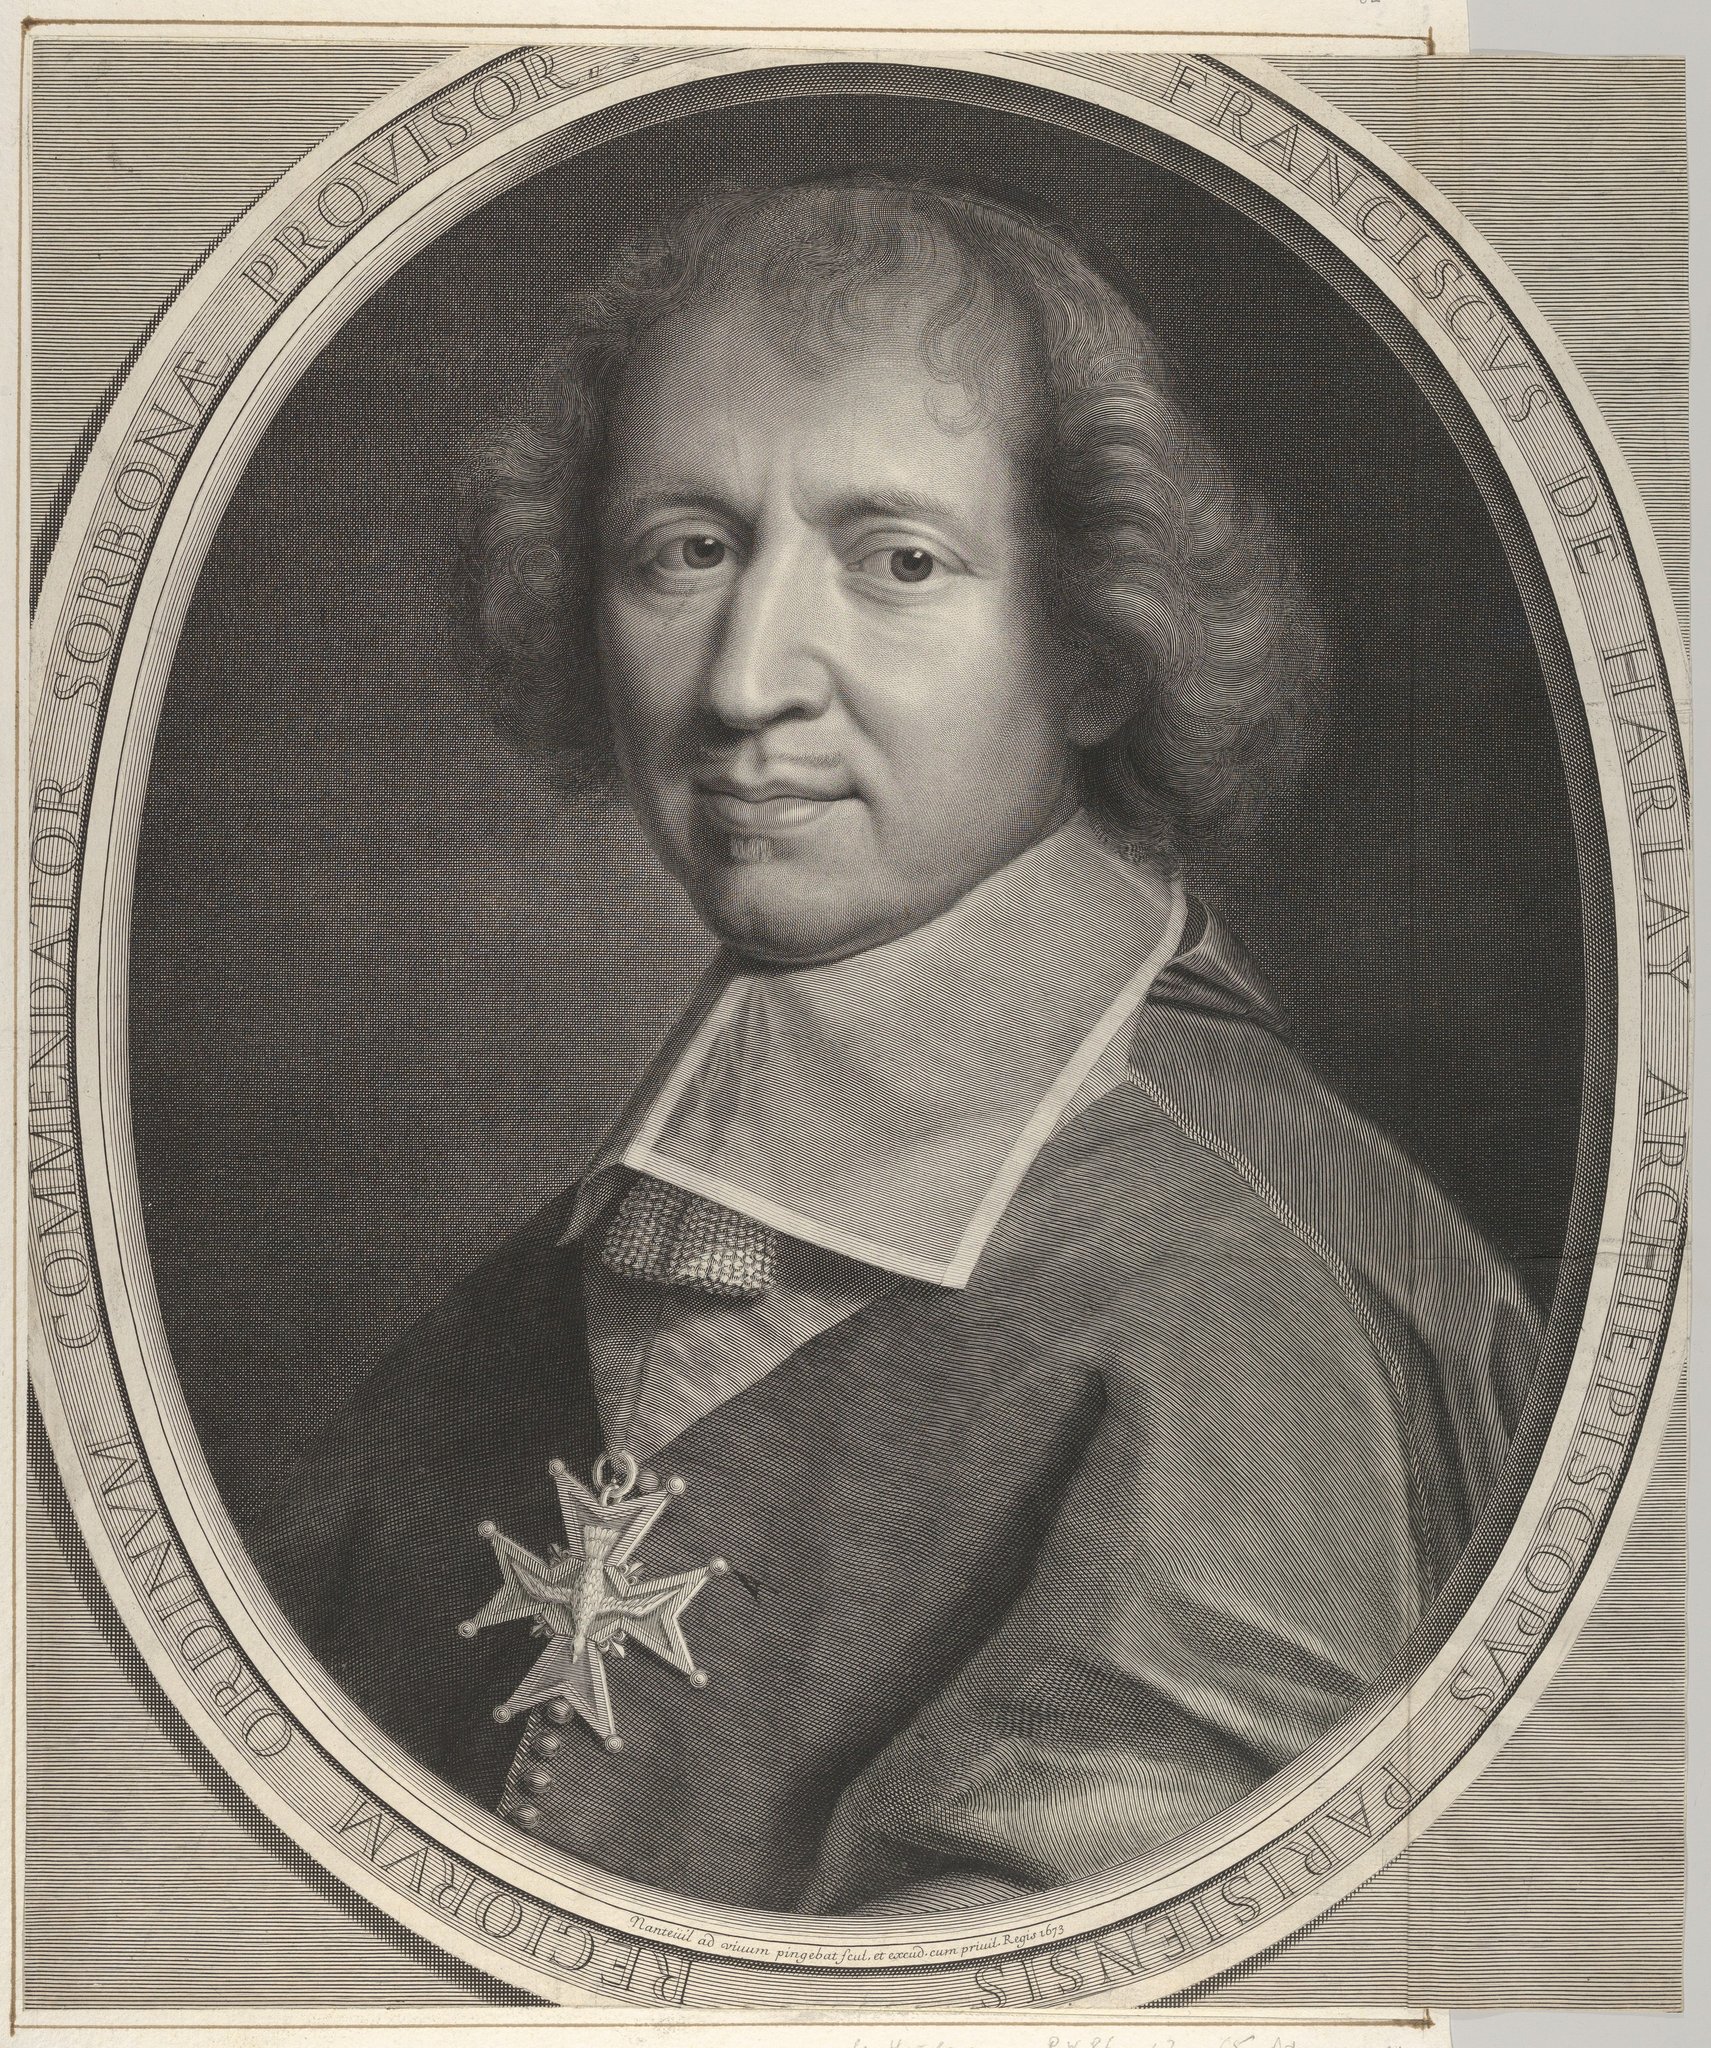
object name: print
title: François de Harlay de Champvallon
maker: robert nanteuil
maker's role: artist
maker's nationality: french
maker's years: 1623-1678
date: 1673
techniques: engraving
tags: men,portraits,cross